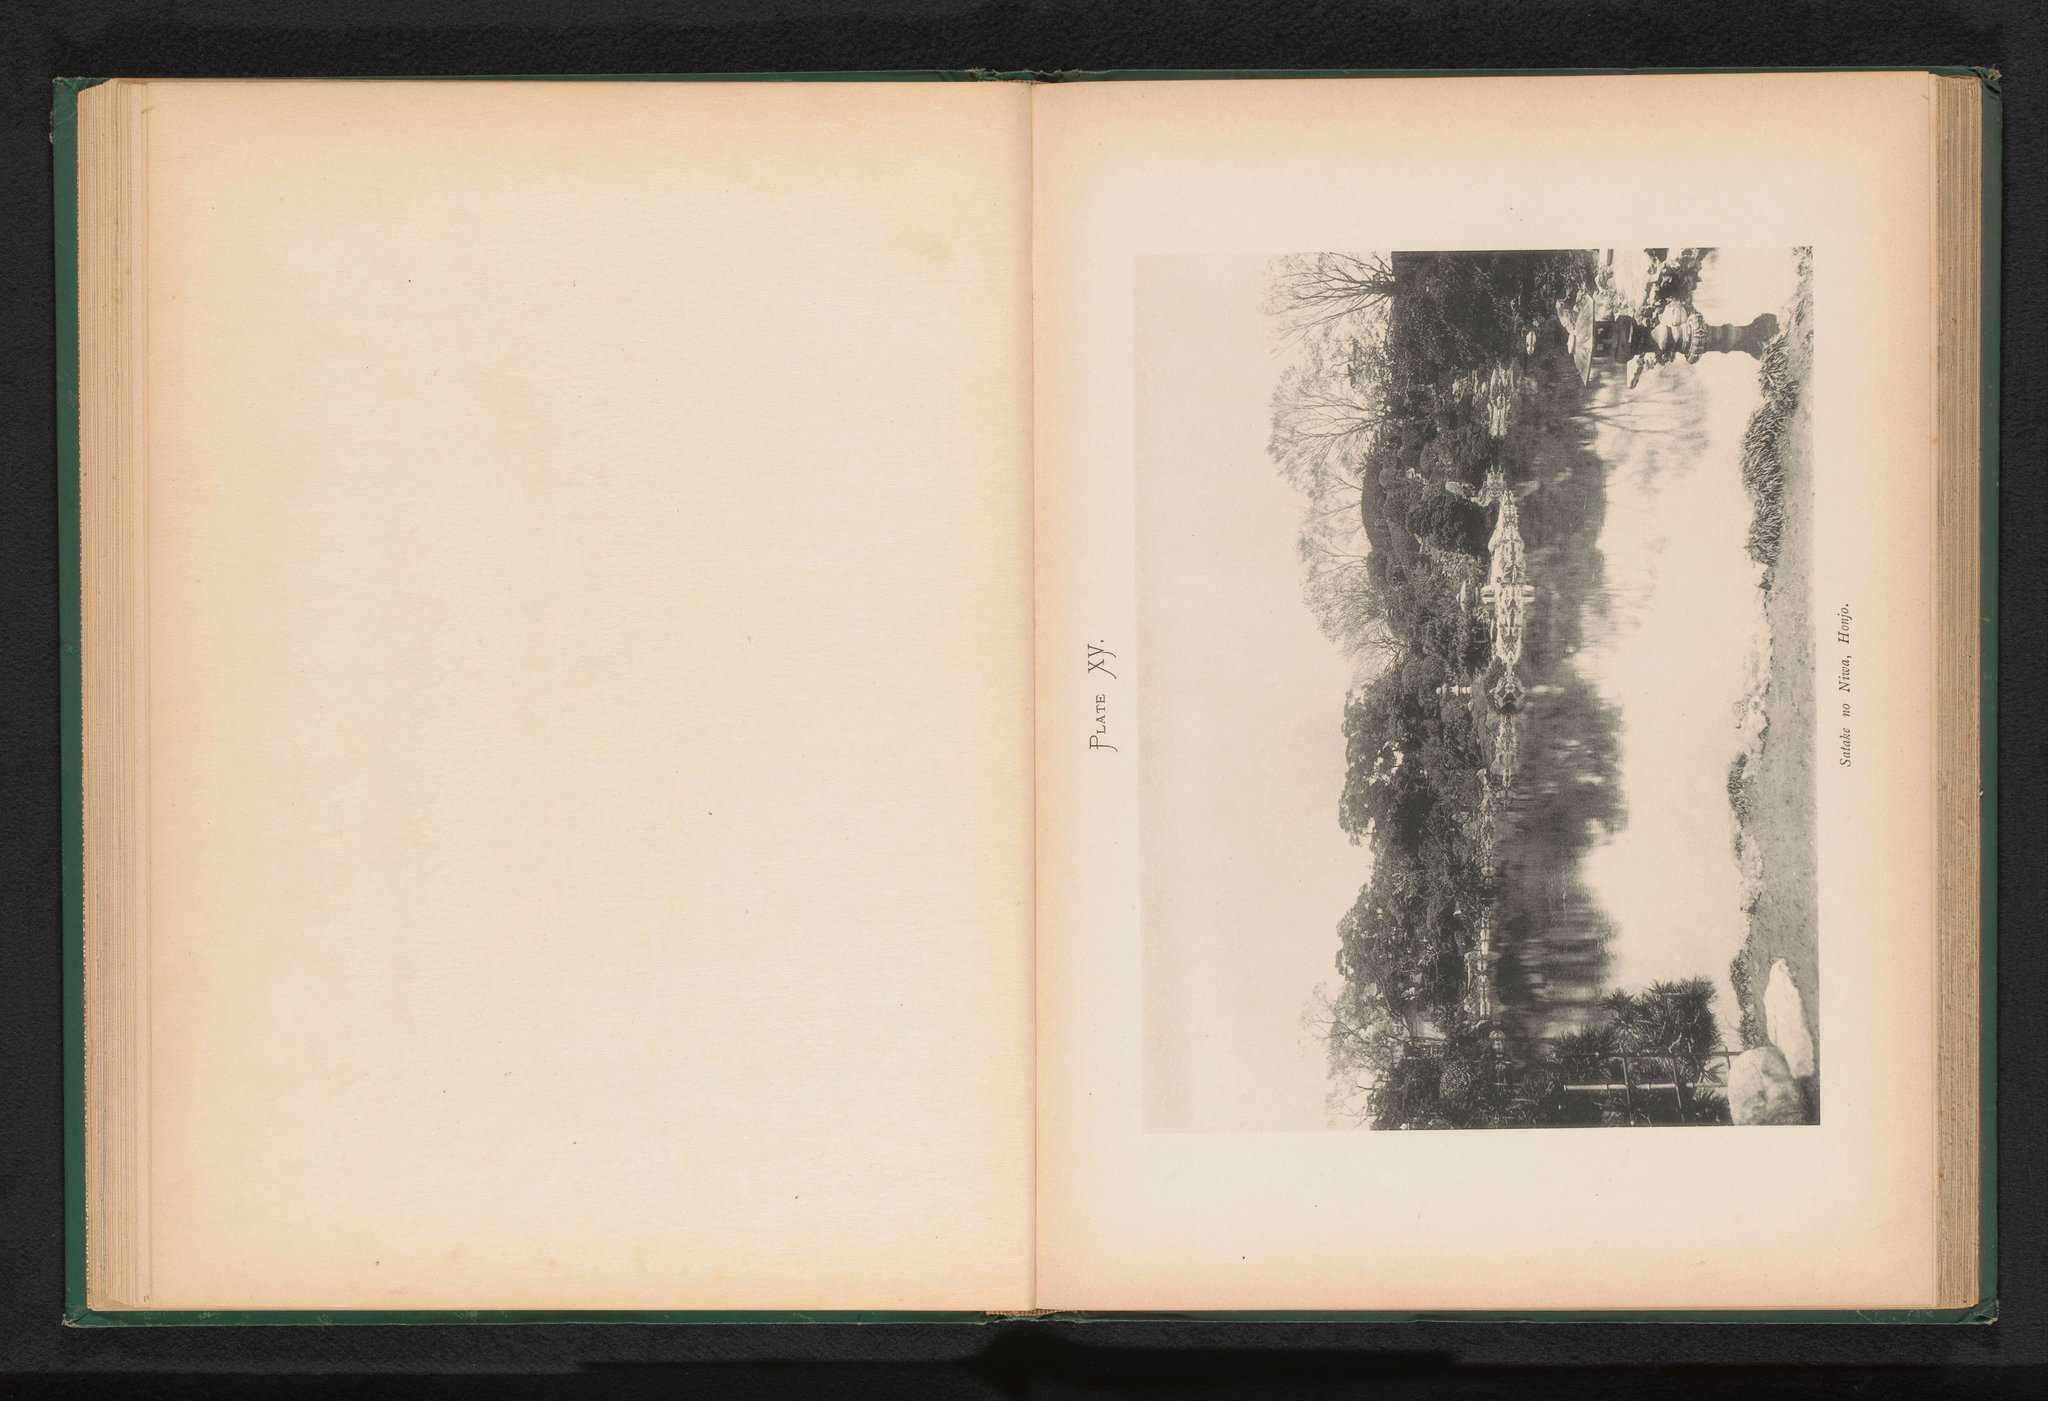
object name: photomechanical print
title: Satake no Niwa, Honjo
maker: kazumasa ogawa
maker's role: auteur, fotograaf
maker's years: 1860-1929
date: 1888-1893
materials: paper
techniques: photograph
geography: tokyo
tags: garden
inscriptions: inscription: ‘Plate XV.’